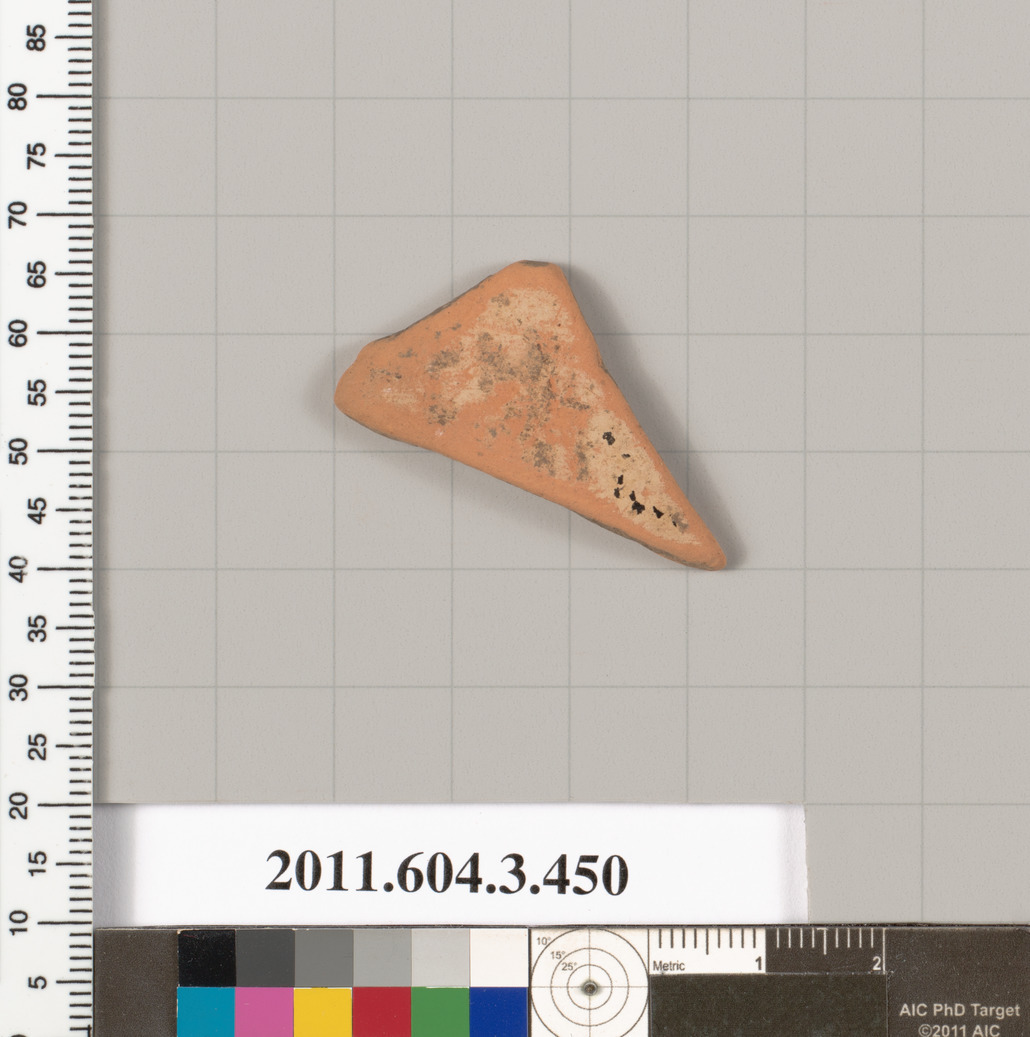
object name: neck amphora fragment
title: Terracotta fragment of a neck-amphora (jar)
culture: greek, attic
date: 490-480 BCE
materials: terracotta